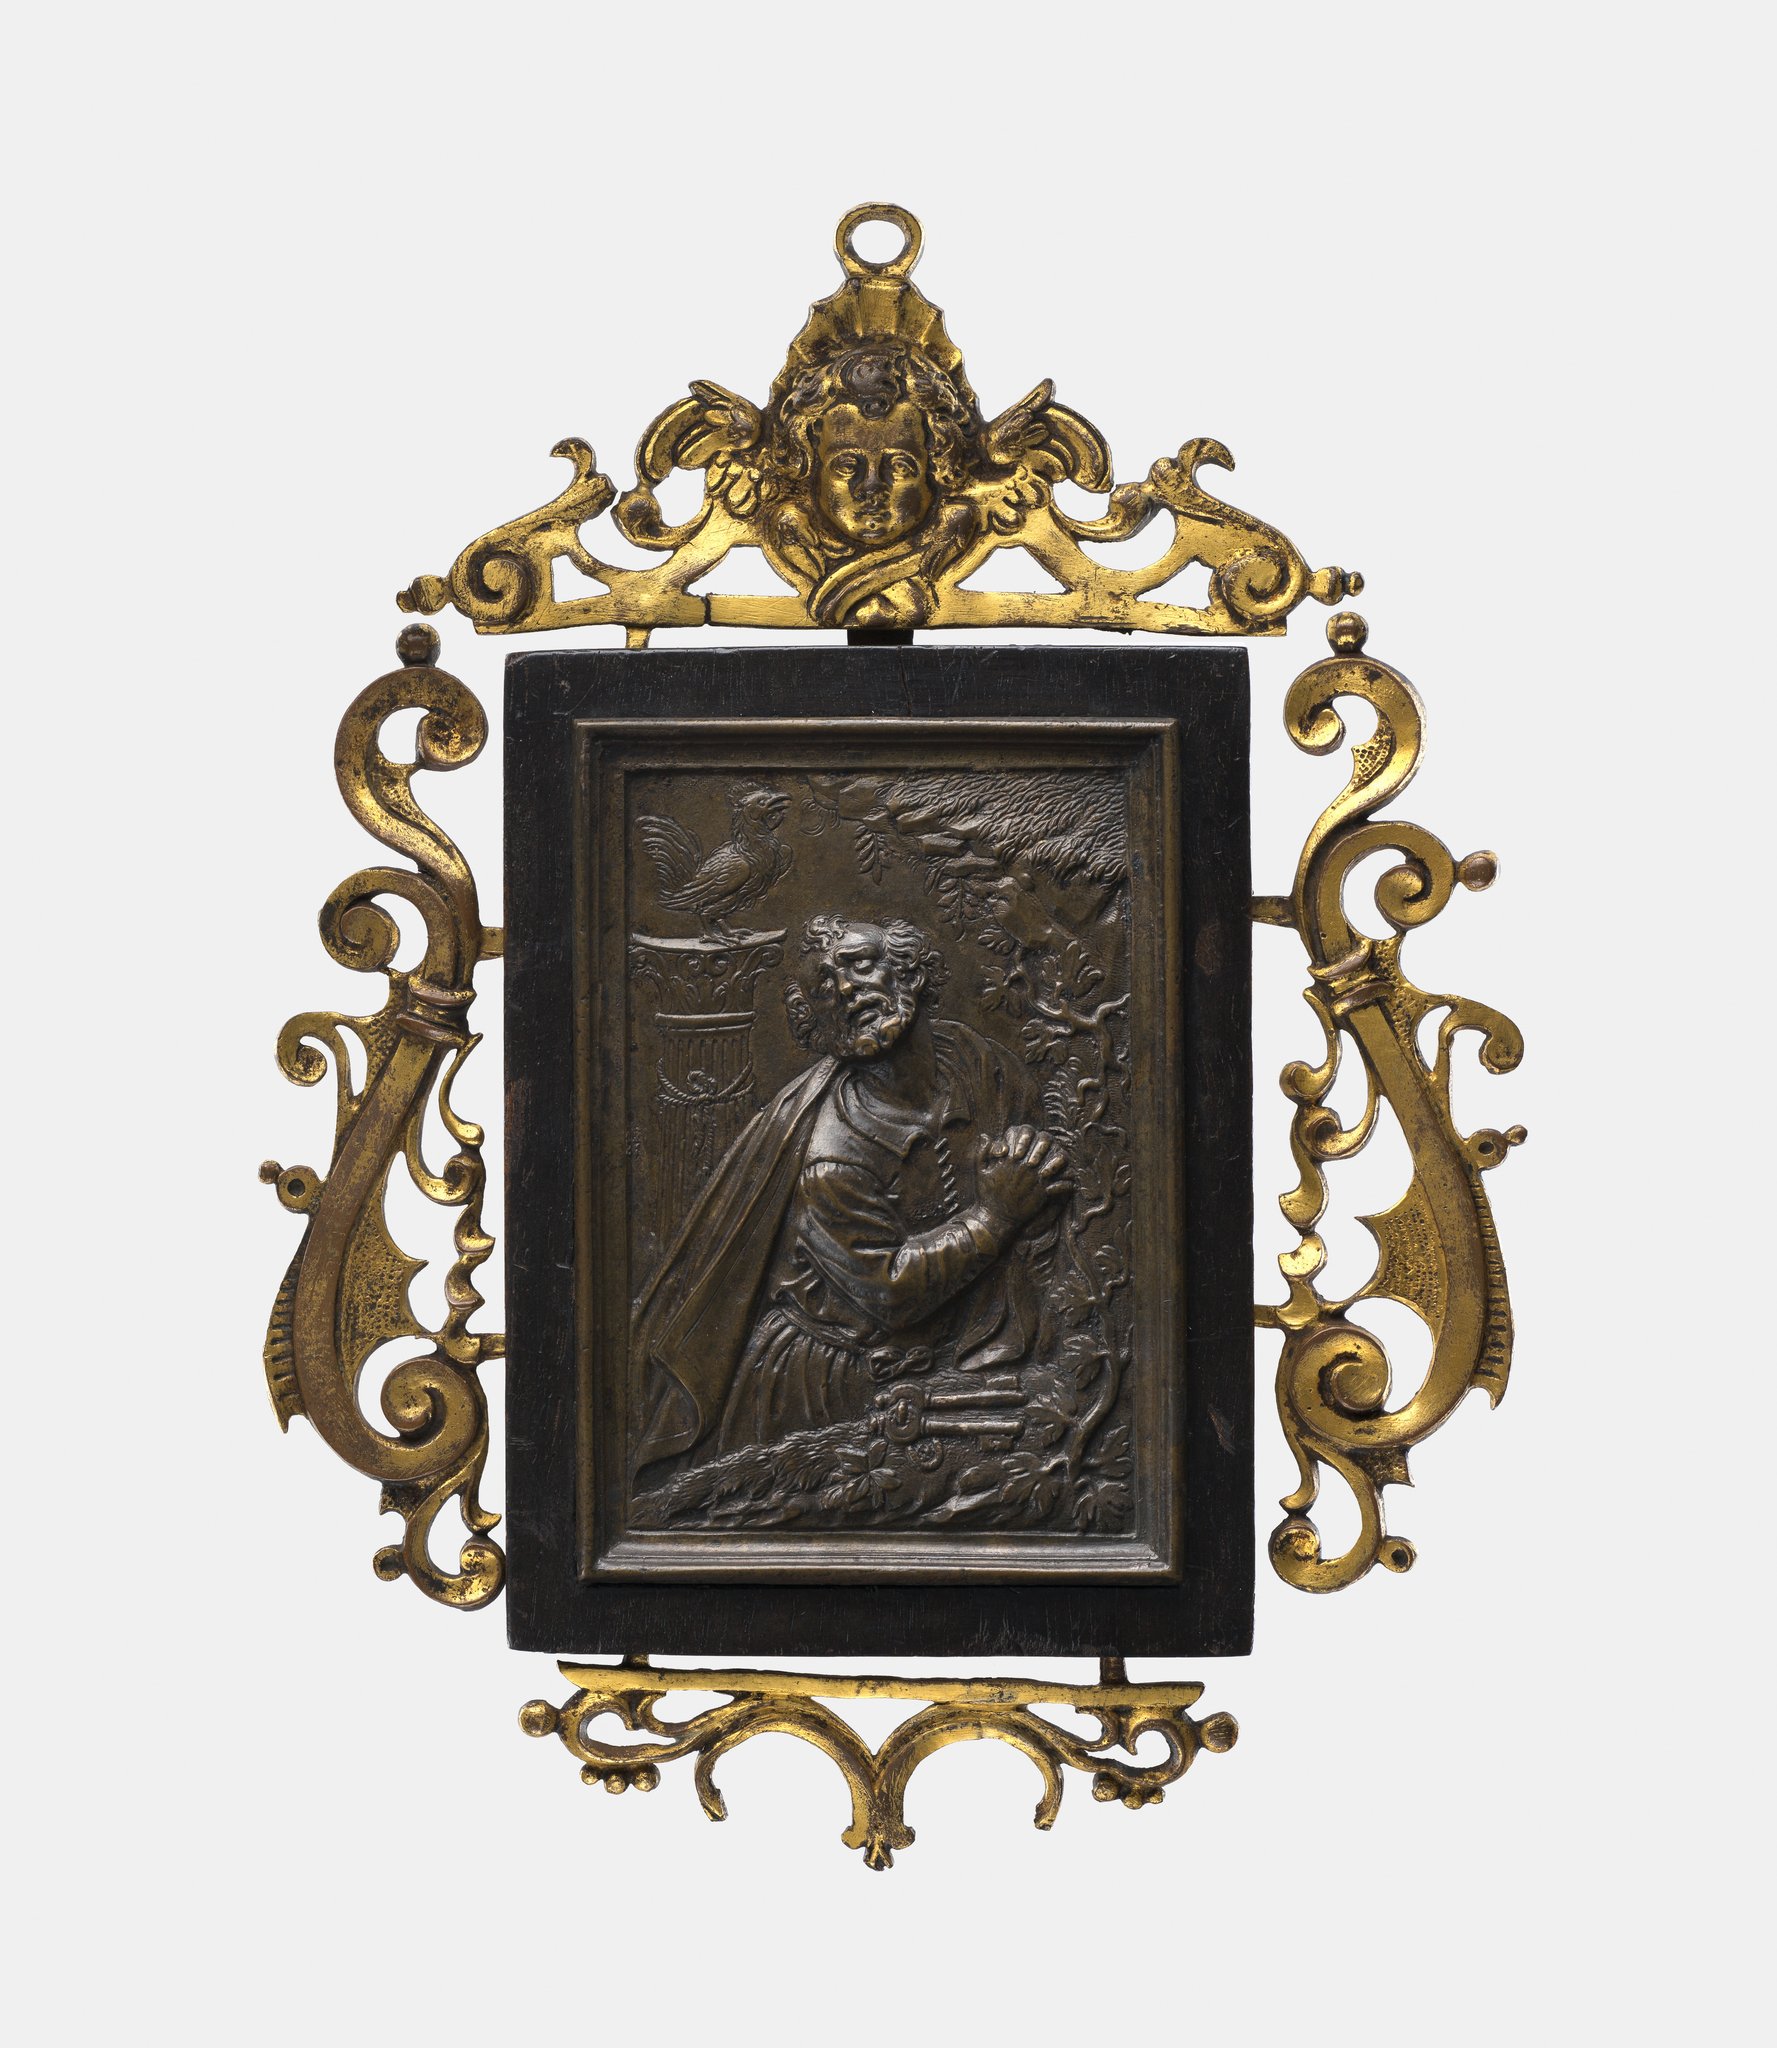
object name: plaquette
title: St. Peter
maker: Anonymous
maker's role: artist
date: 1600